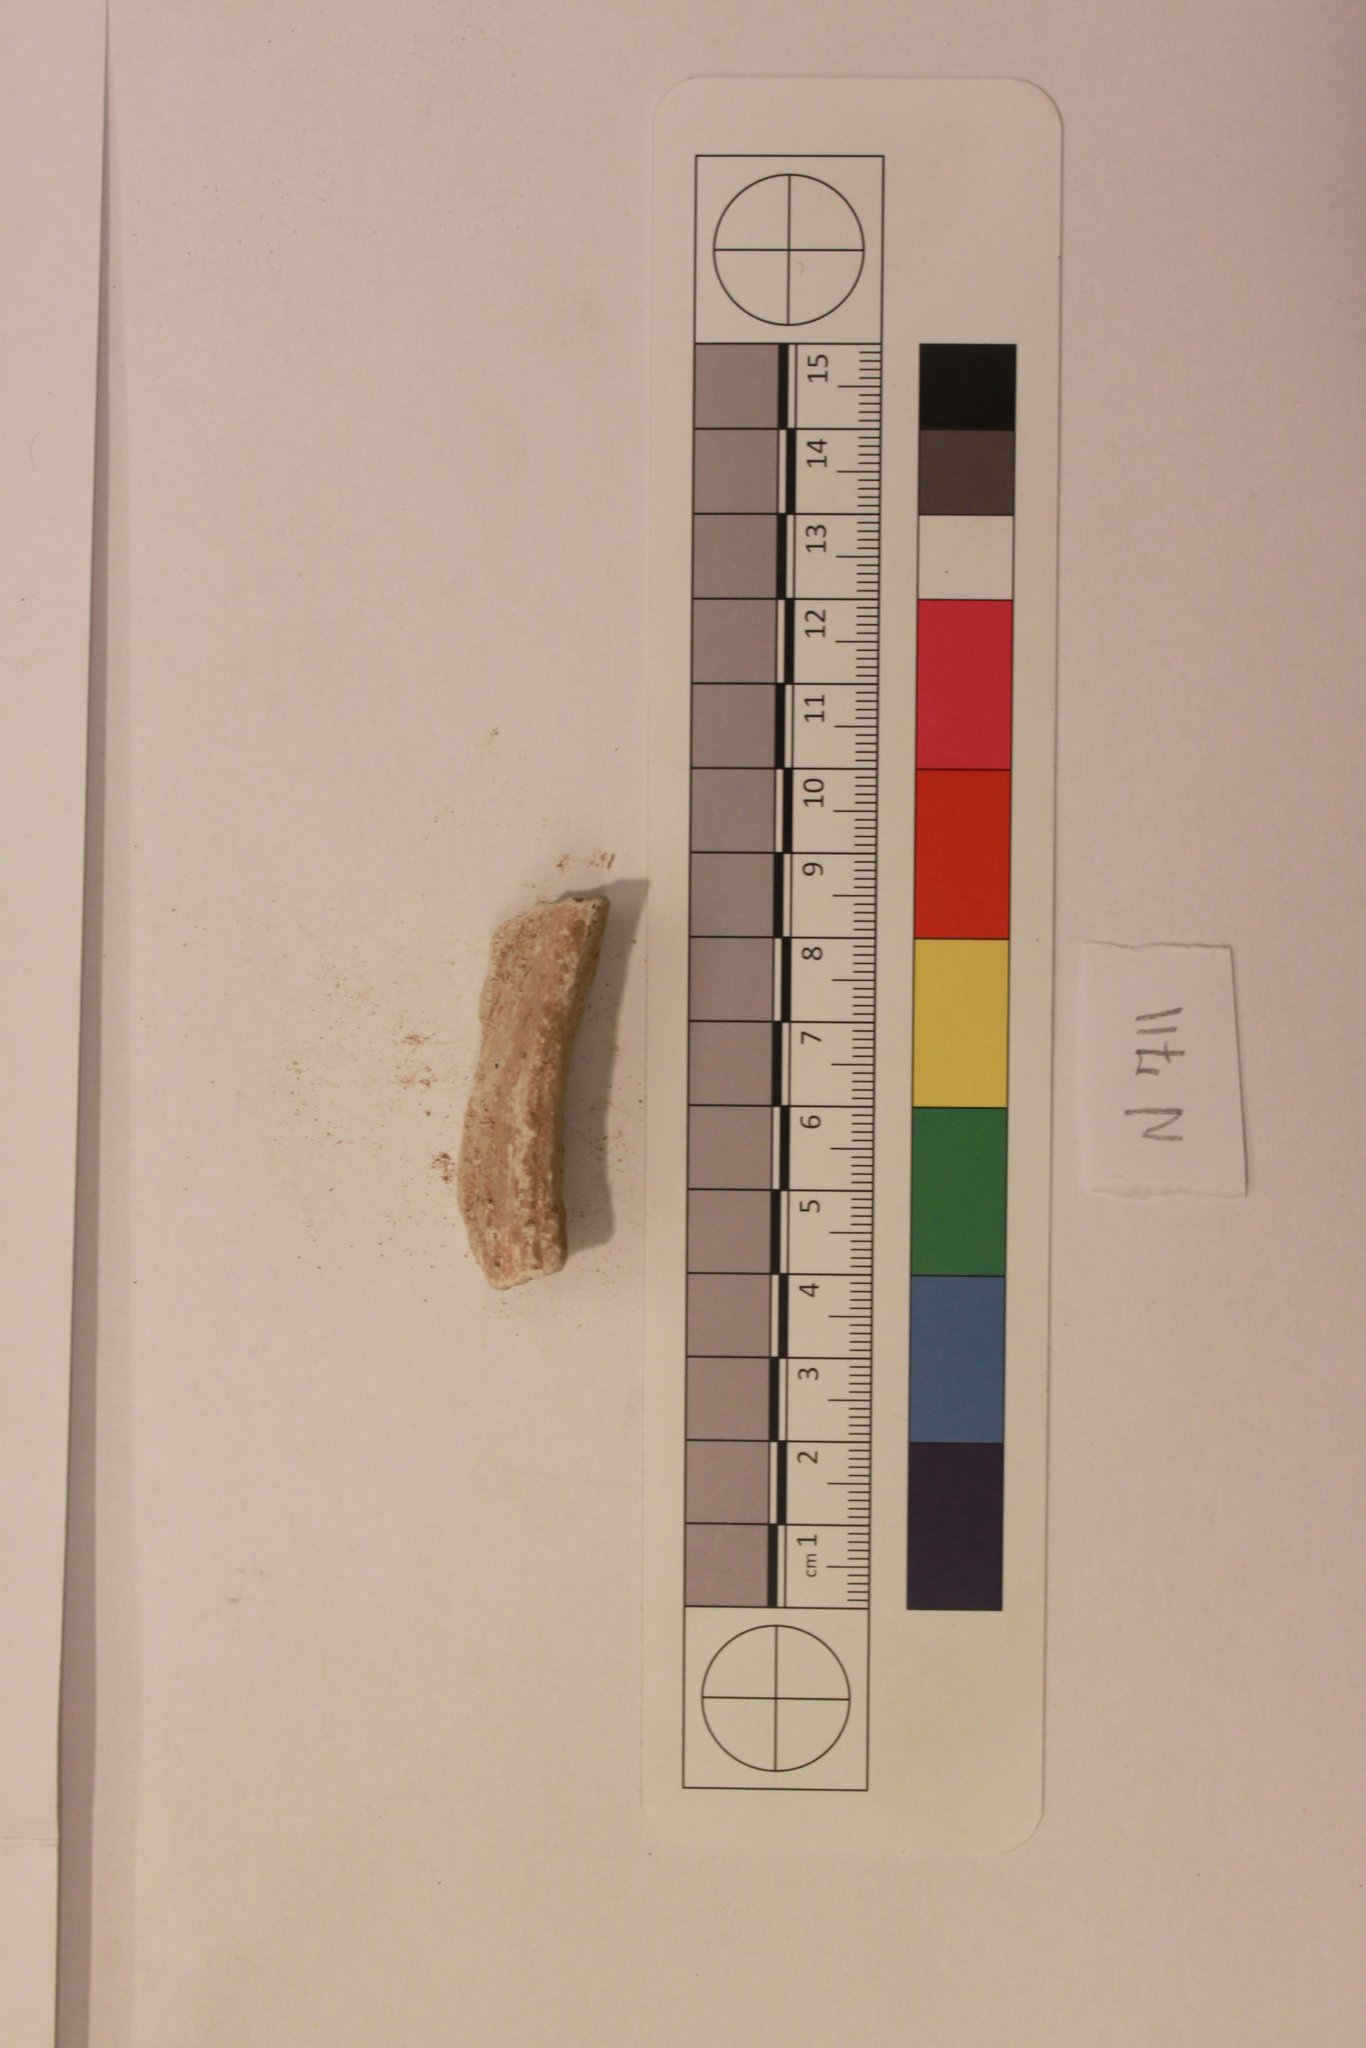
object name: fragment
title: Stucco Fragment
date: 701-1200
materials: plaster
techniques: carving, painting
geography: iran